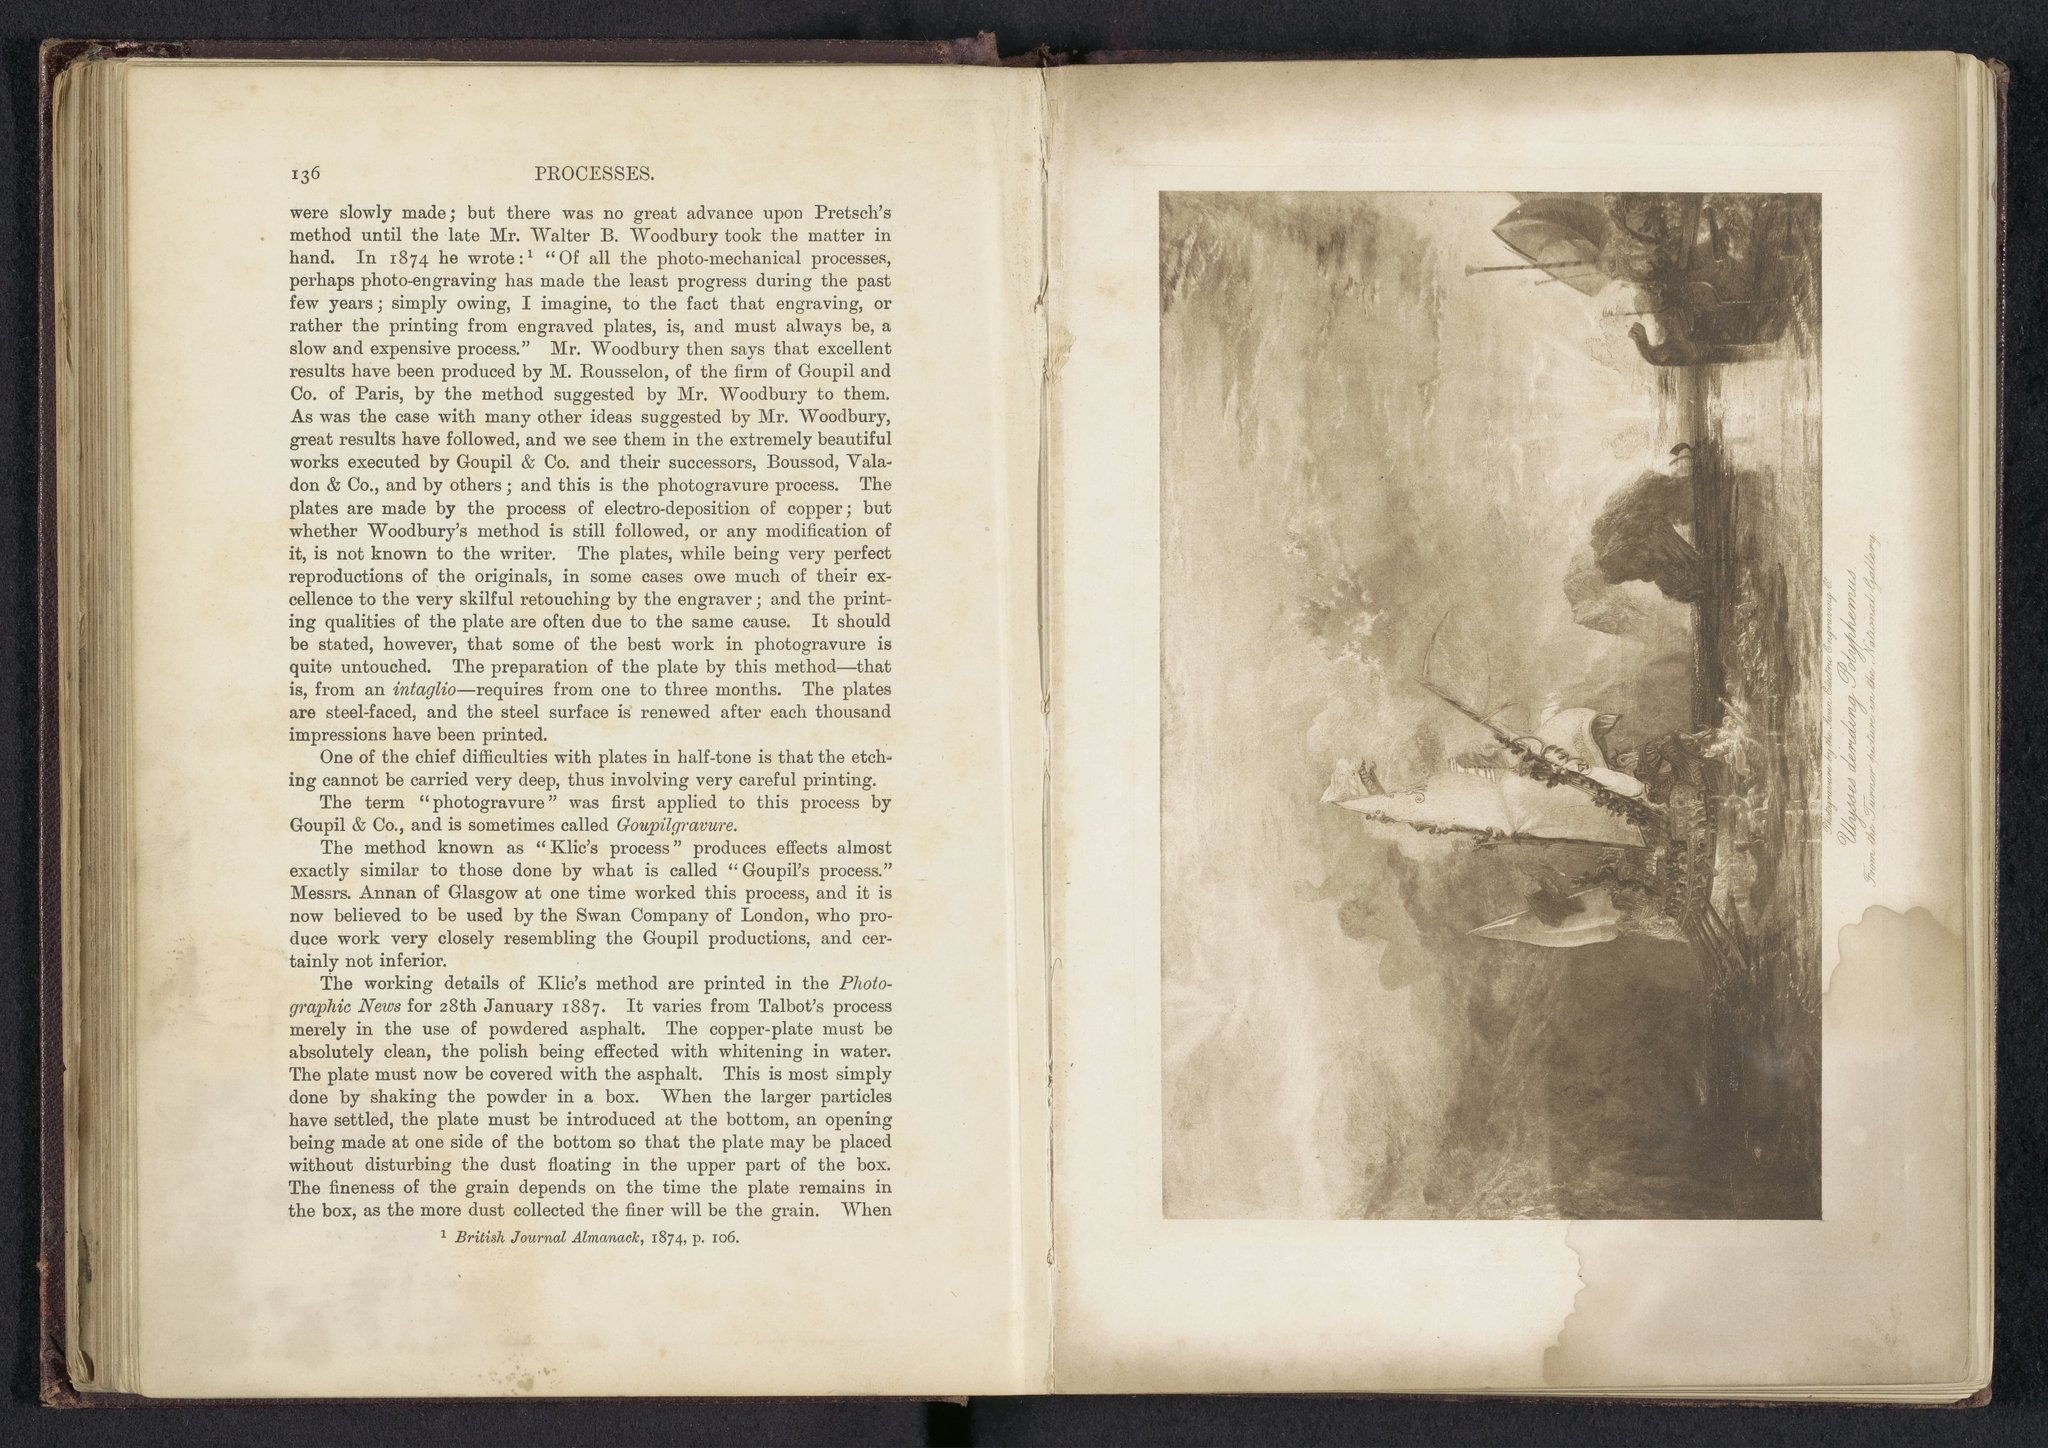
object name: page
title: Ulysses deriding Polyphemus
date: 1889-1899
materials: paper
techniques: photoaquatint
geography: clewer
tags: polyphemus hurls a rock at ulysses' departing ships